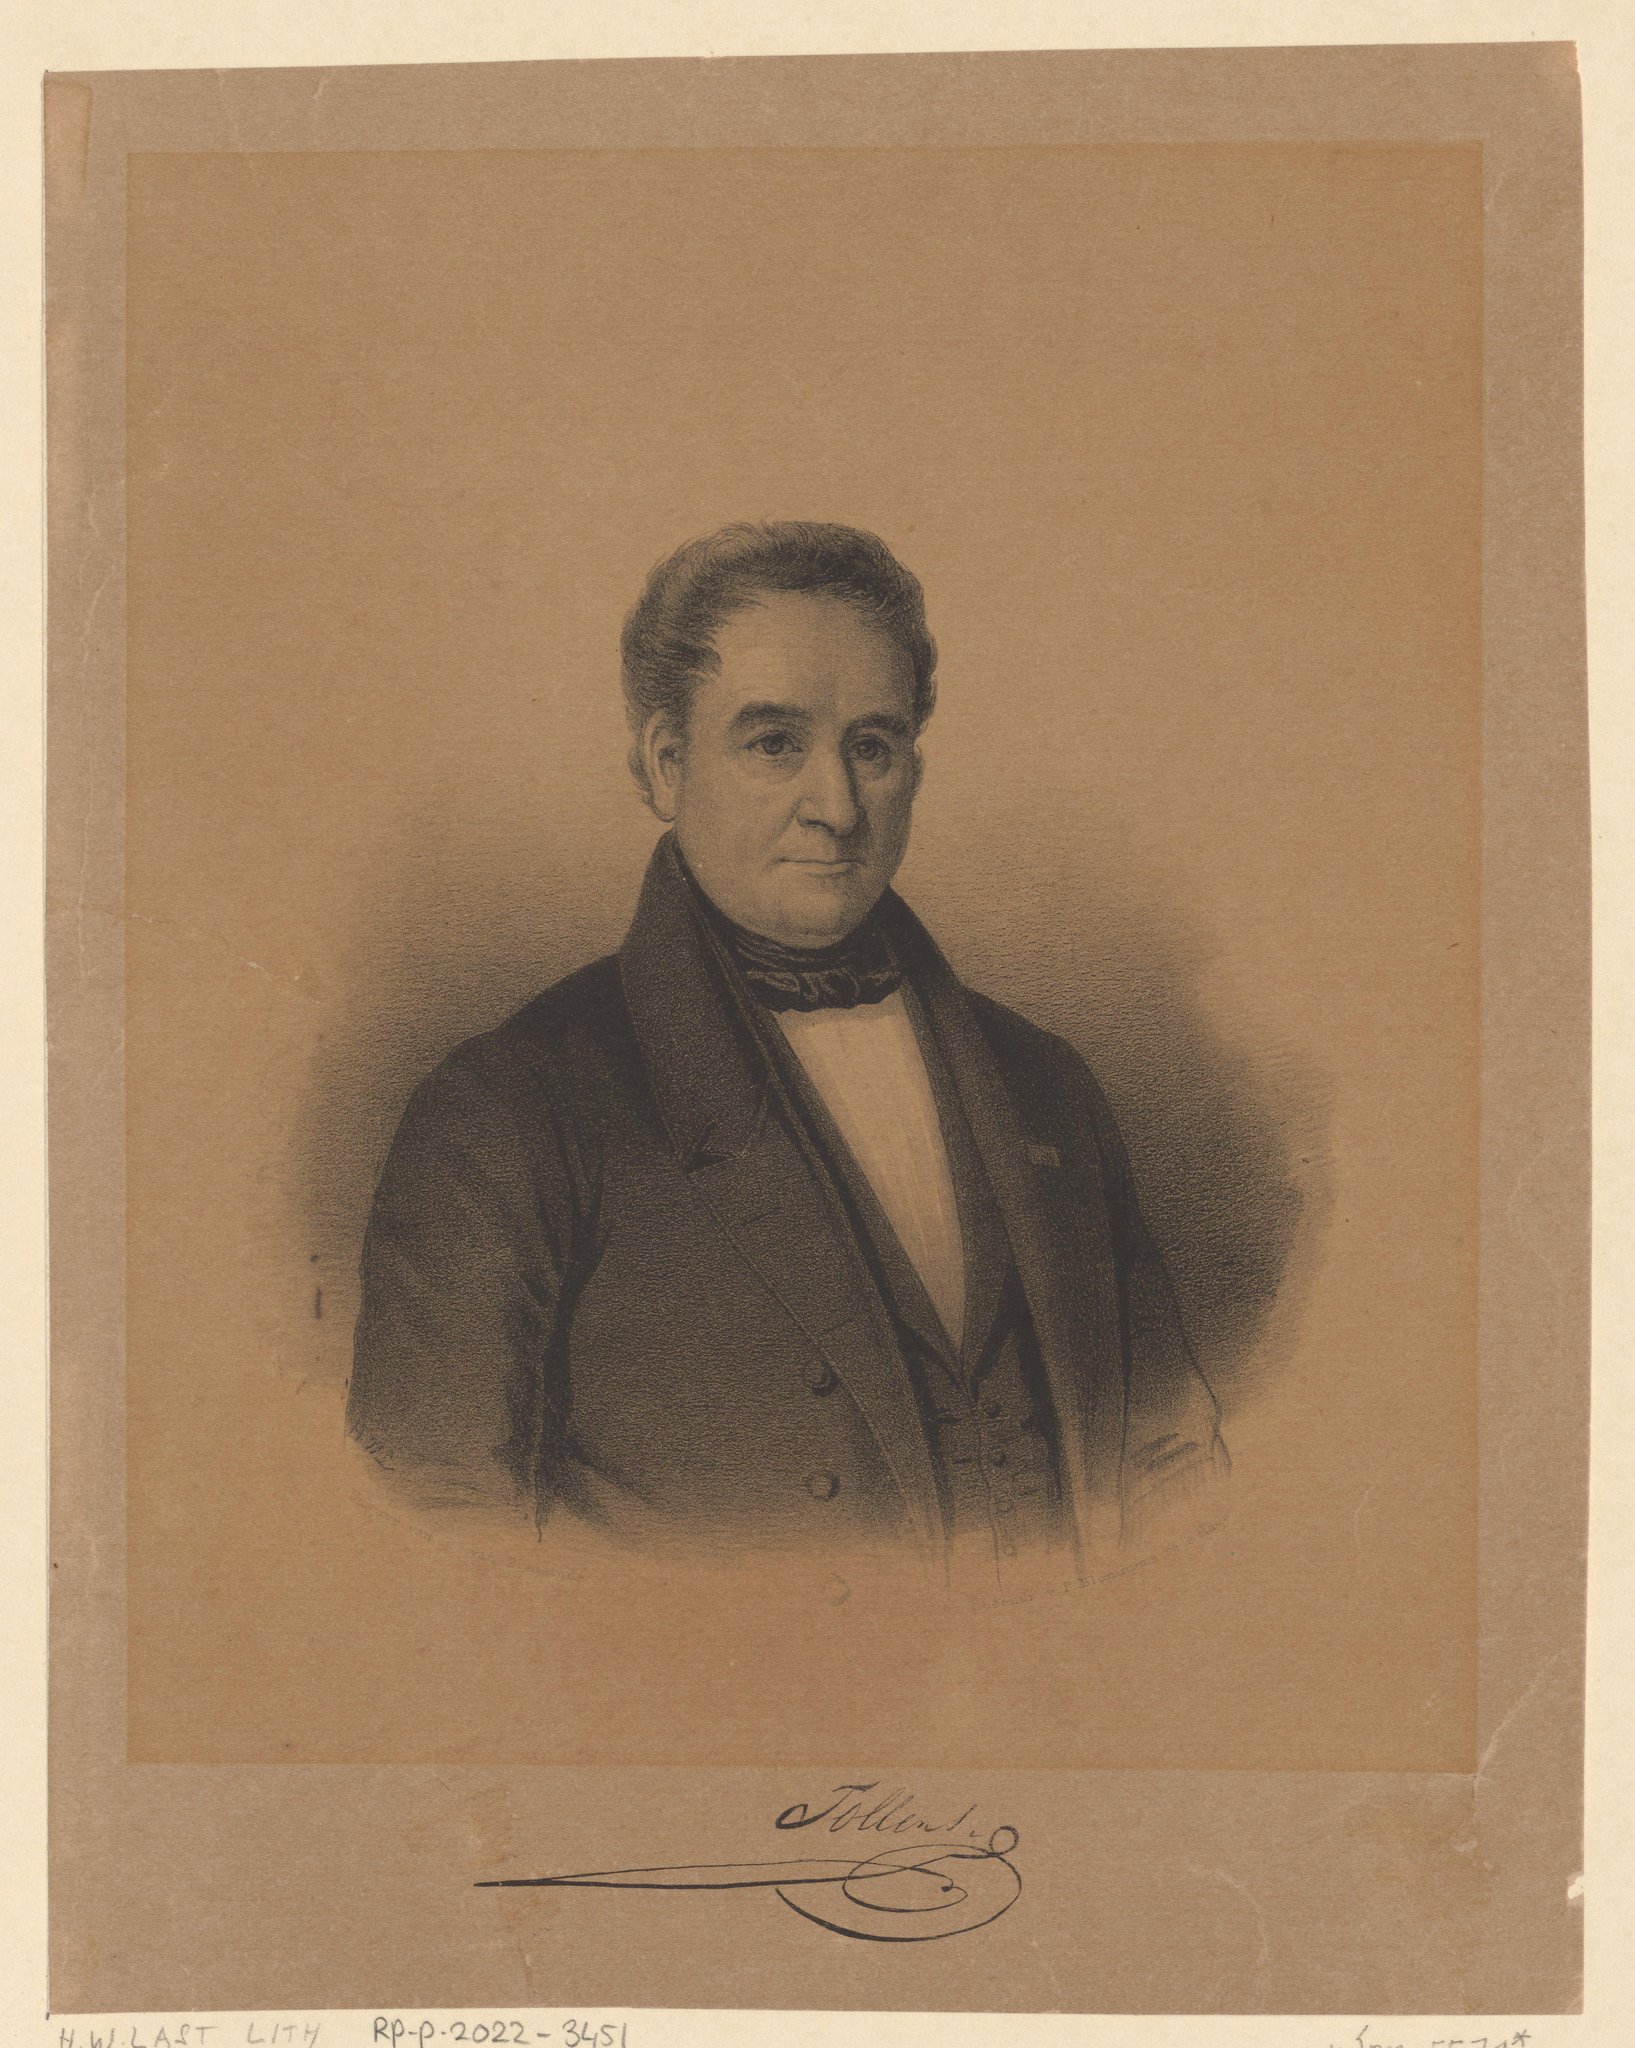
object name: print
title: Portret van Hendrik Tollens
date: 1847-1873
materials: paper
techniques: tone lithography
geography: netherlands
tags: rotterdam, hendrik tollens, historical persons, portrait of a writer